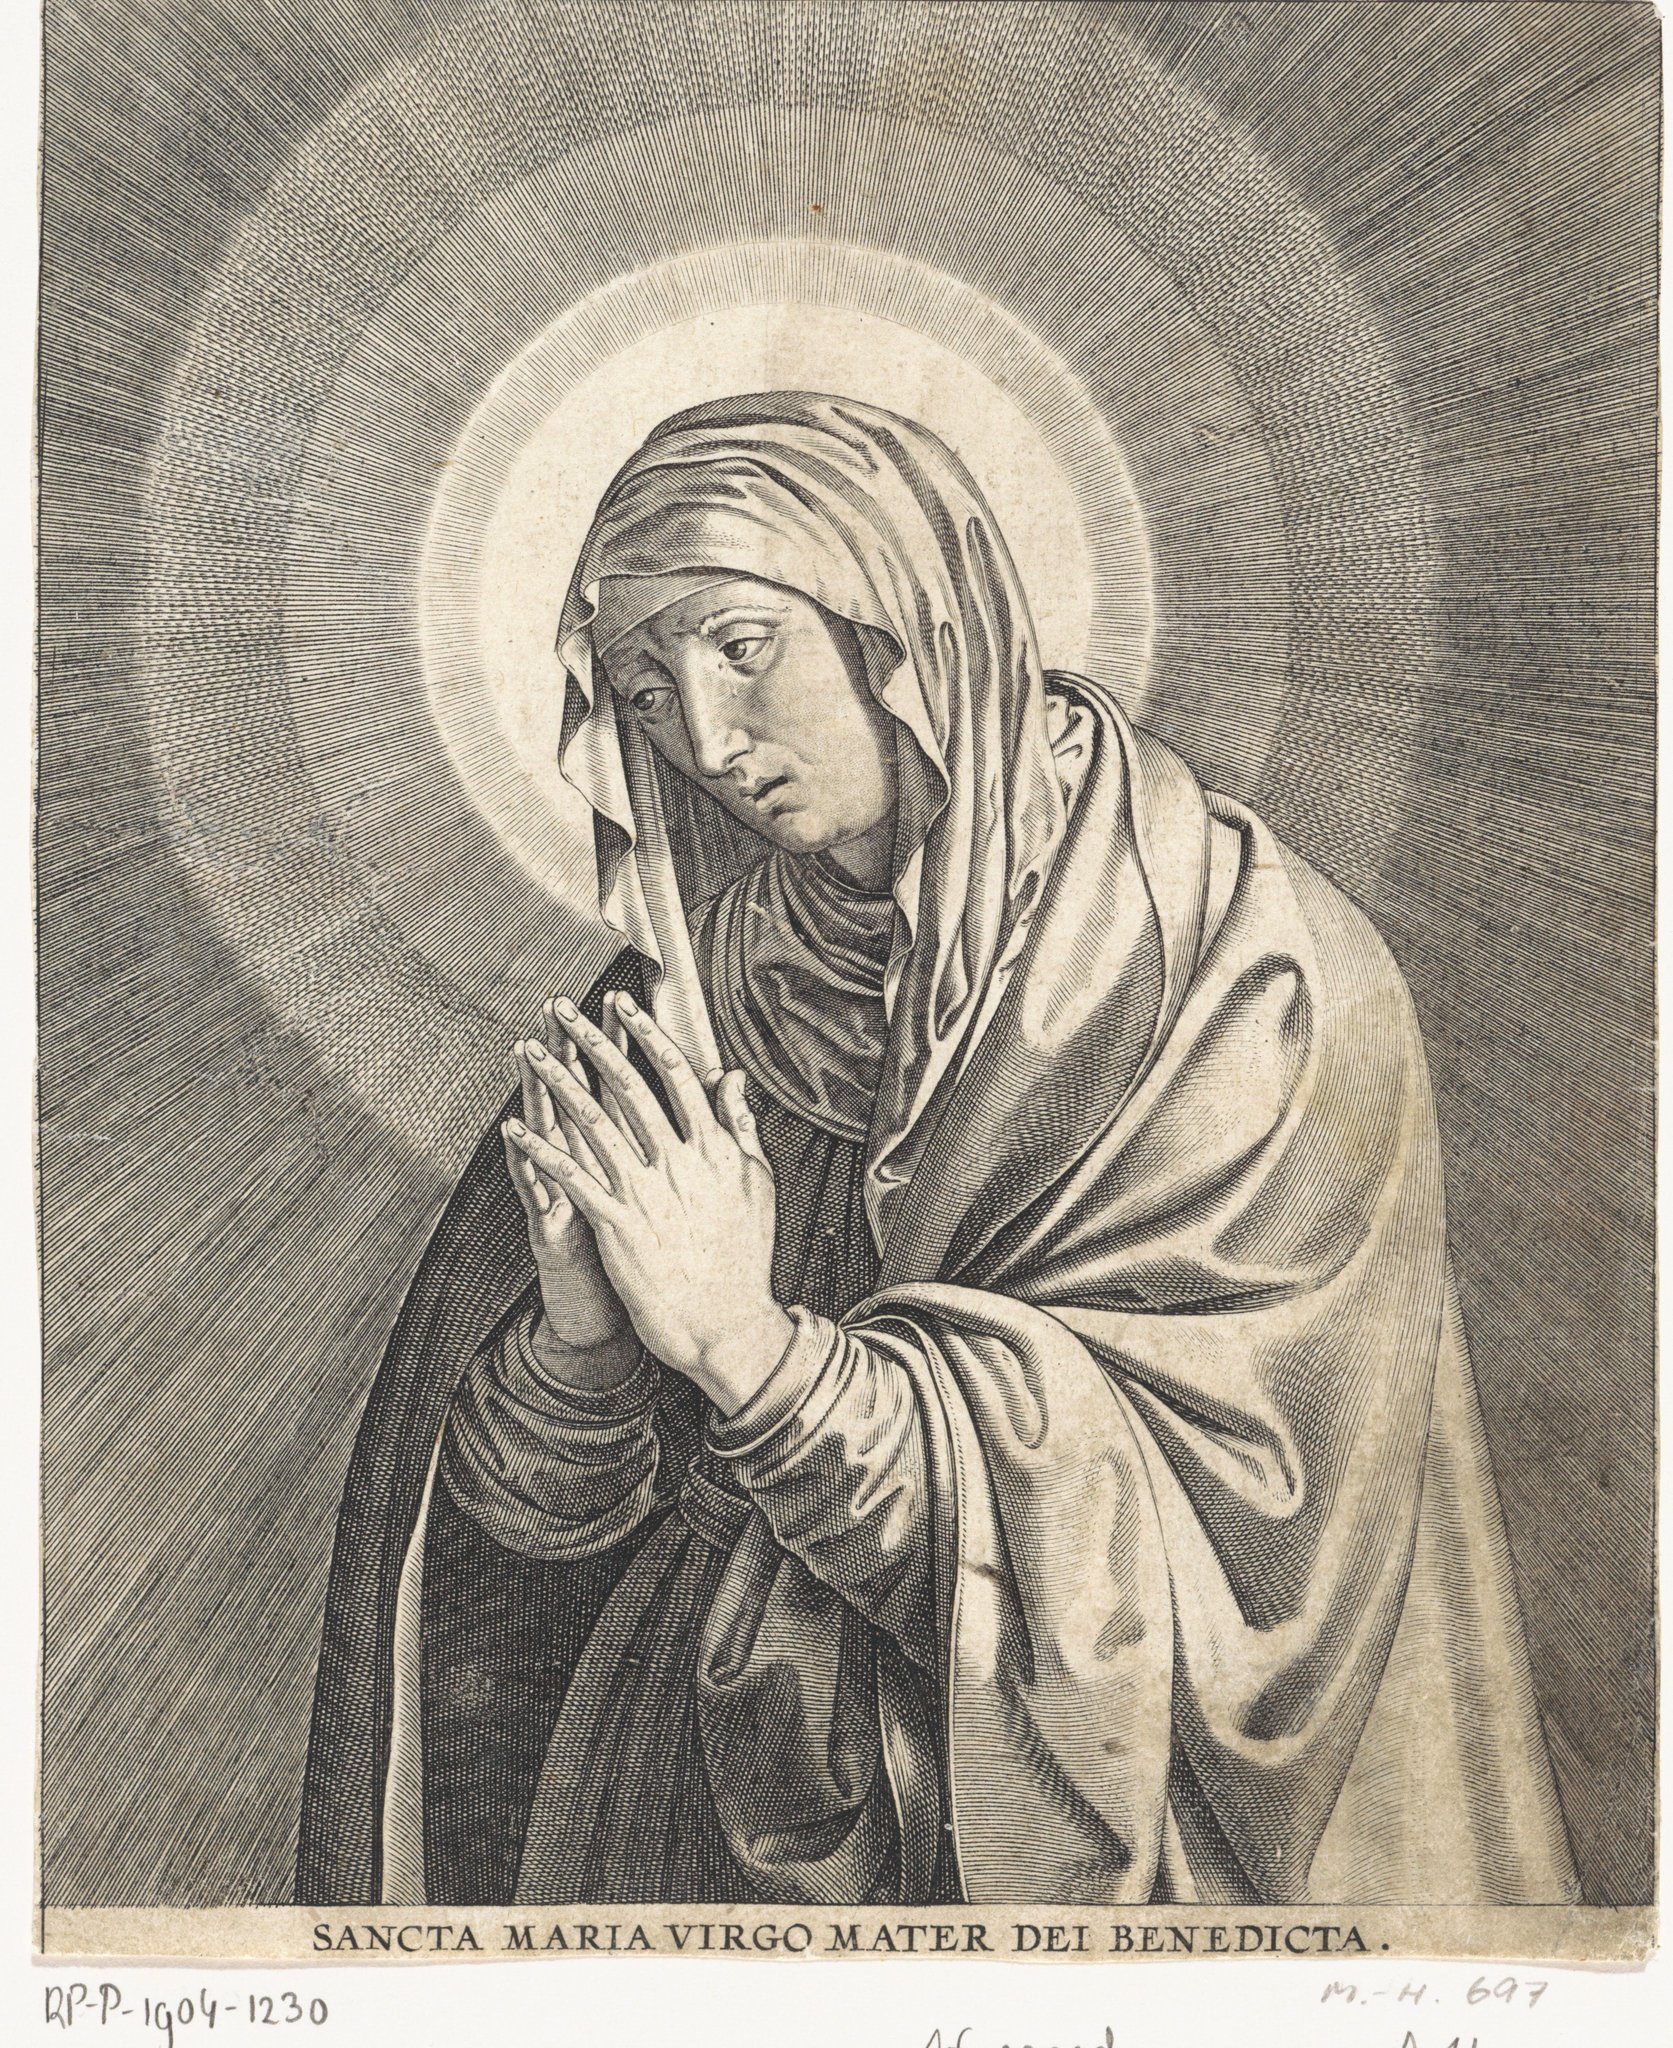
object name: print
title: Sancta Maria Virgo Mater dei Benedicta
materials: paper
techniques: engraving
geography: antwerp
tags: 'mater dolorosa'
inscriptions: collector's mark: Lugt 2228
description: De rouwende Maria met haar handen gevouwen in gebed. Achter haar hoofd een aureool.